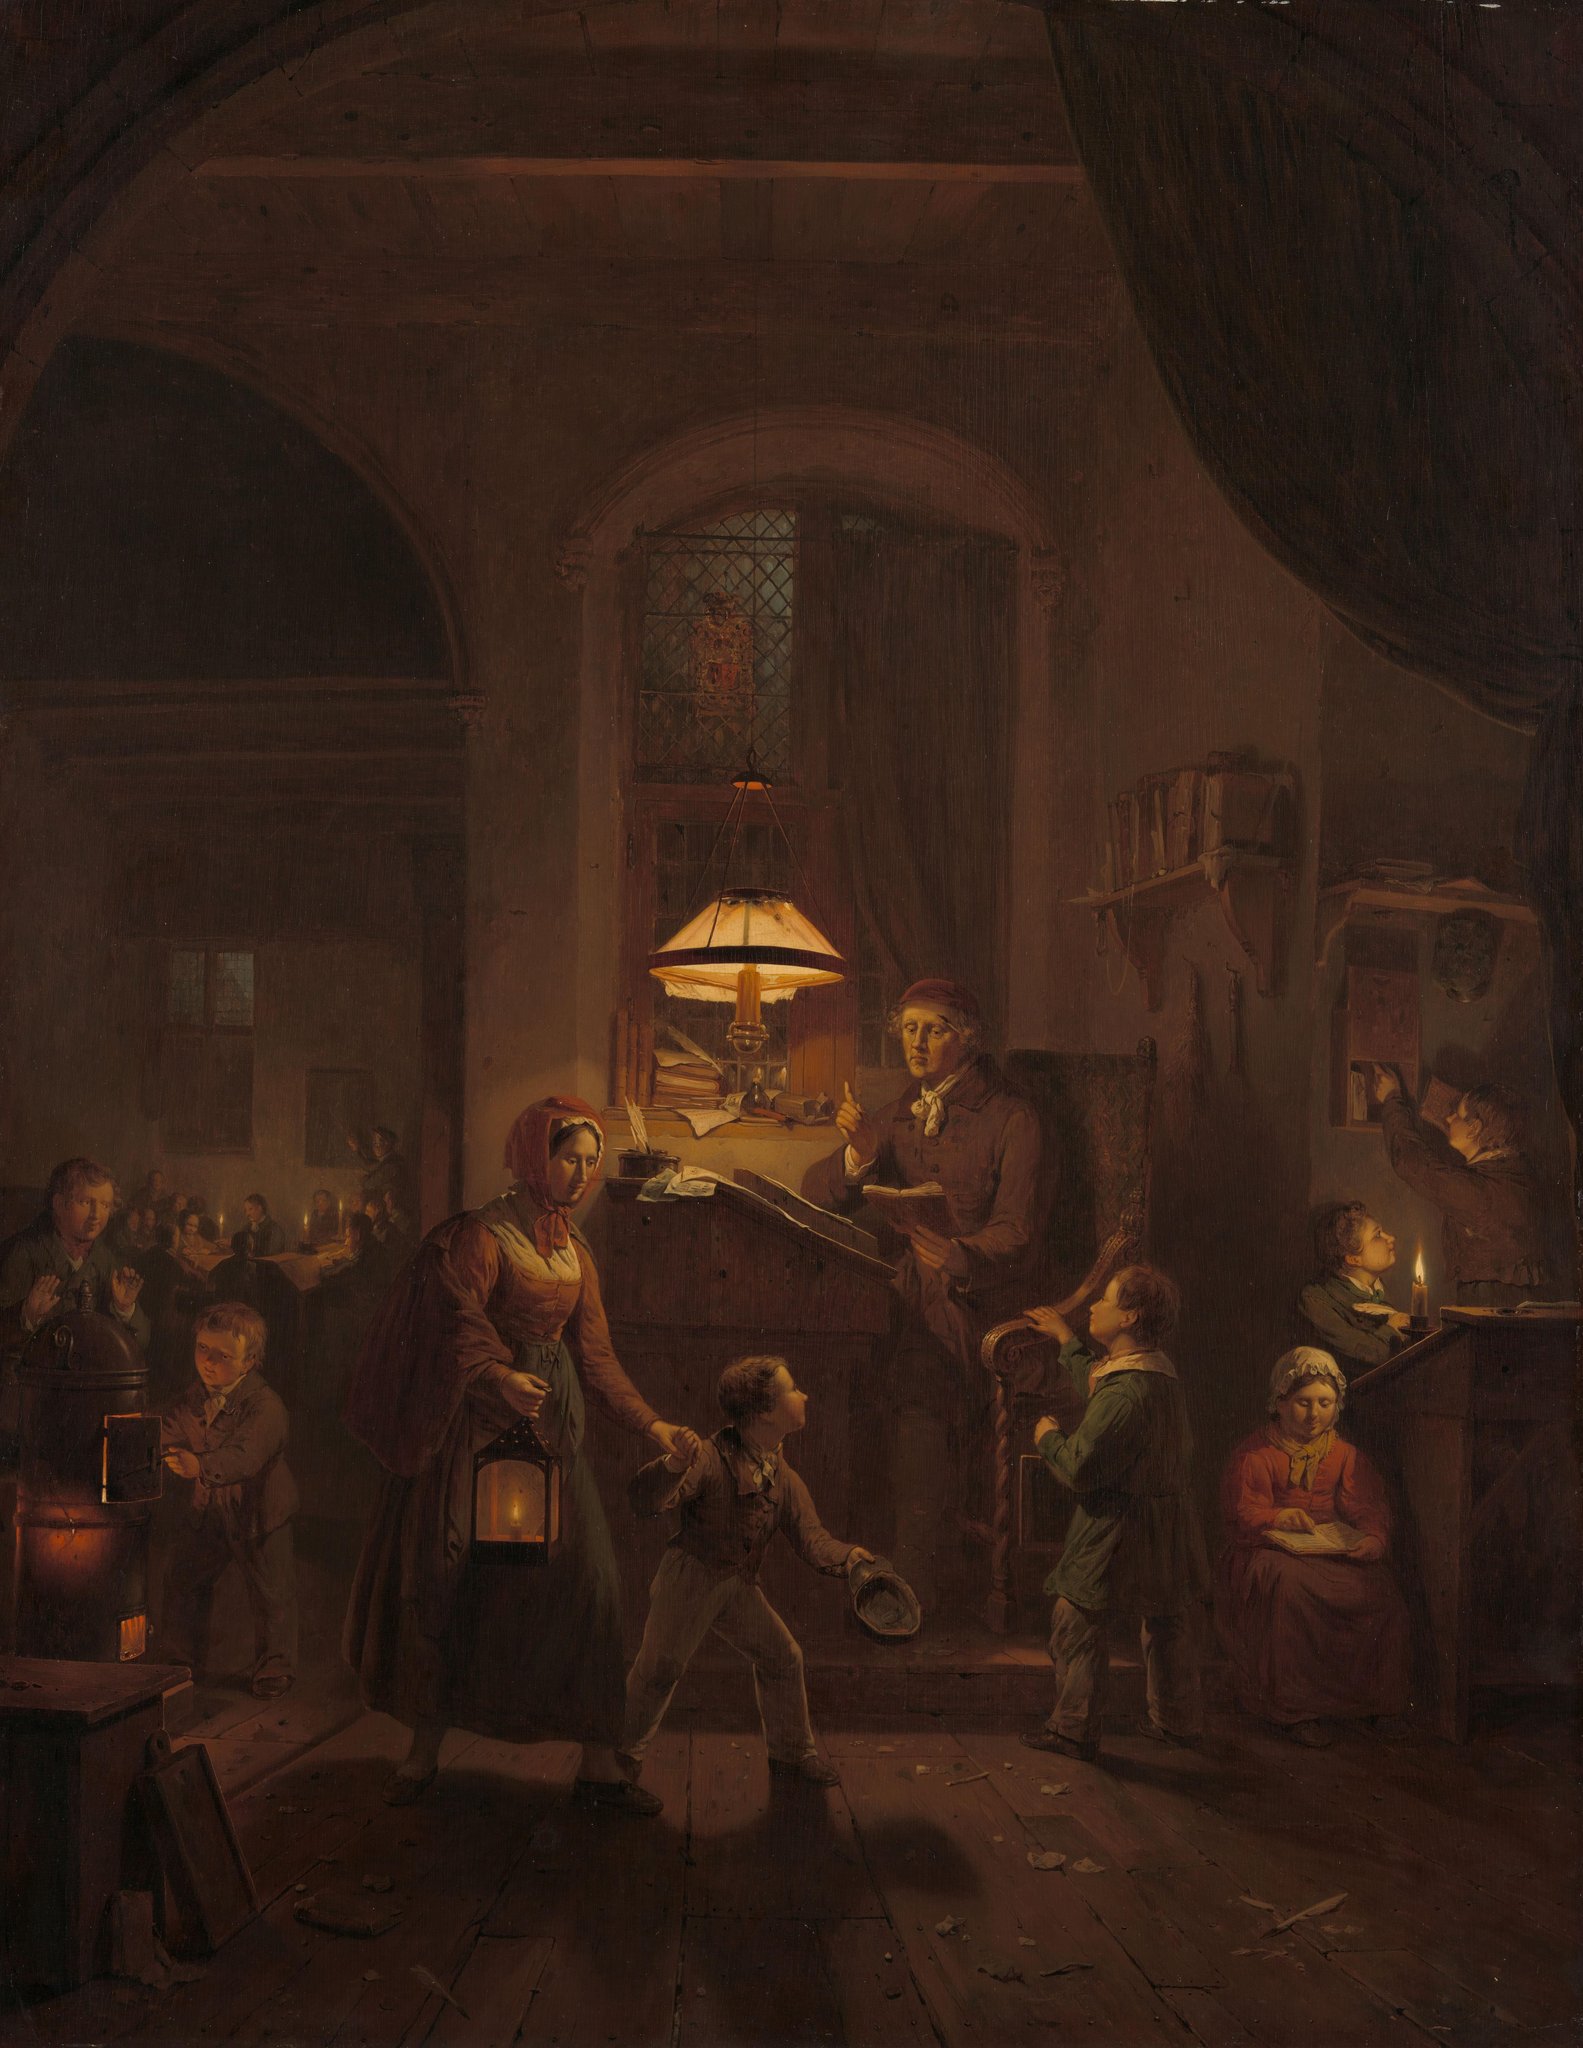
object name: painting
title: The Night School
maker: george gillis haanen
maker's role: draughtsman, painter, print maker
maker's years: 1807-1881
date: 1835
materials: oil, panel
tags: lantern, being brought to school, first school-day, elementary school; class, form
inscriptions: signature and date: ‘G.G. Haanen 1835’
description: Interieur van een avondschool. Een moeder met een lantaarn brengt haar zoontje naar school. In het midden de meester achter zijn lessenaar. Rechts leerlingen bij kaarslicht bezig met lezen. Links twee jongens bij een kachel.